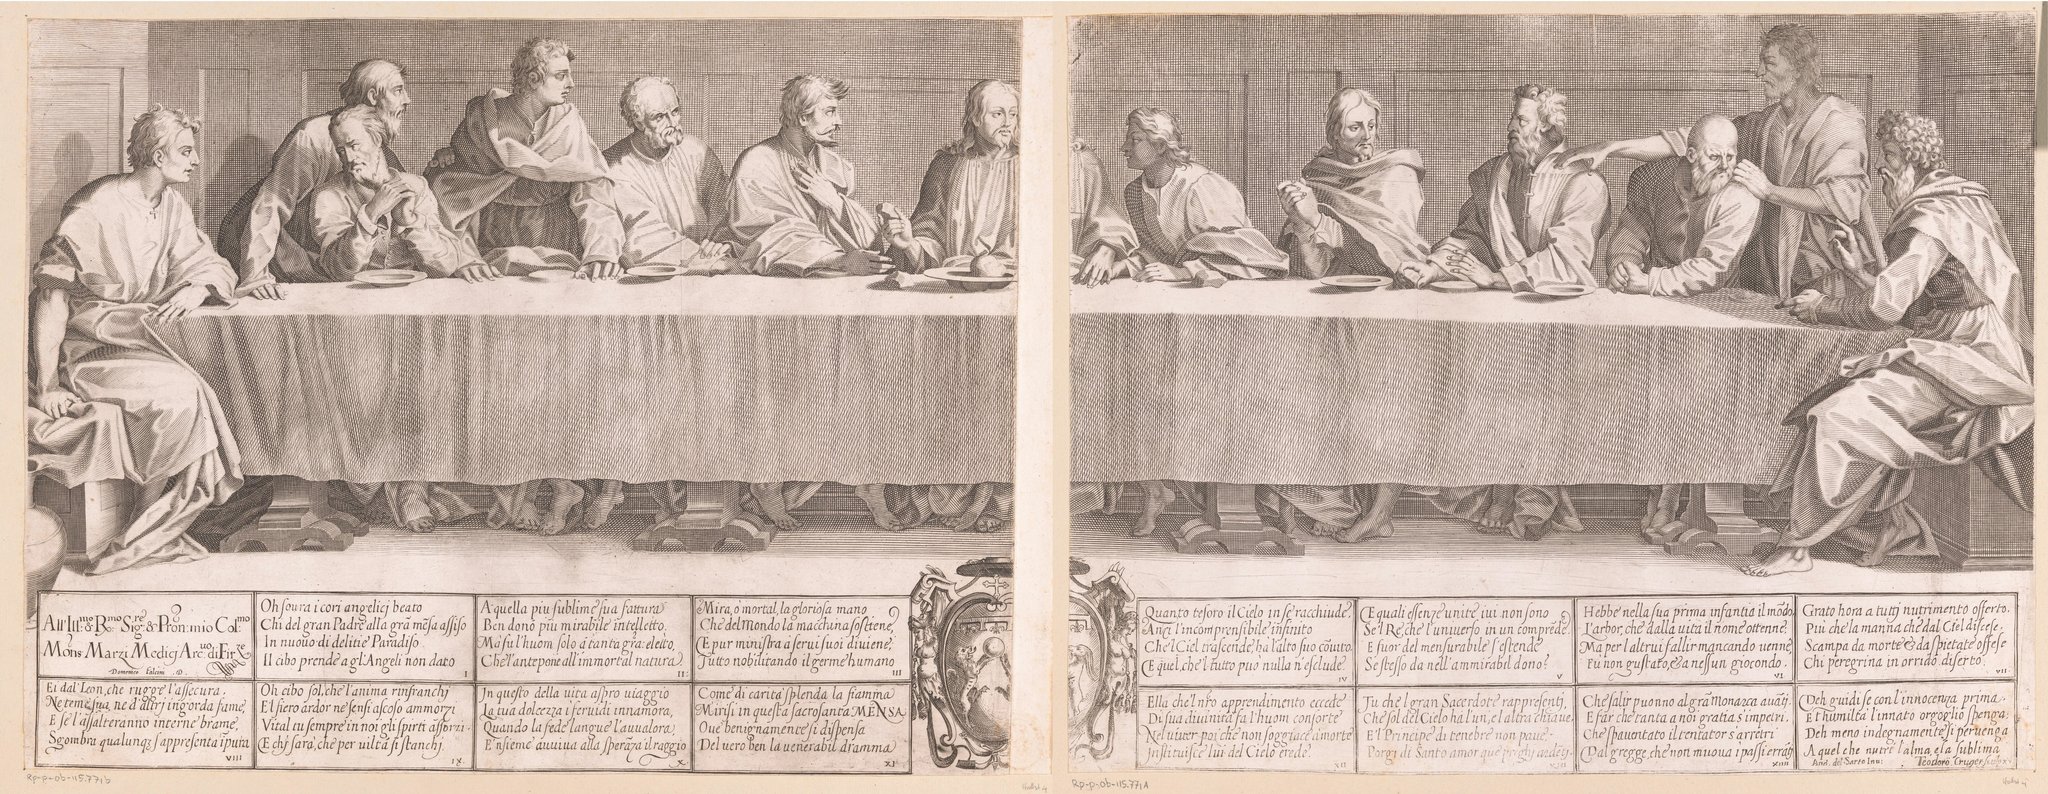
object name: print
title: Het Laatste Avondmaal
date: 1590-1621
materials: paper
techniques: engraving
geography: florence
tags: last supper (in general) (matthew 26:21-35; mark 14:18-31; luke 22:3, 22:15-23; john 13:21-38)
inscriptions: collector's mark: Lugt 240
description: Dit object is omwille van een betere presentatie virtueel samengevoegd, maar bestaat fysiek uit losse onderdelen.